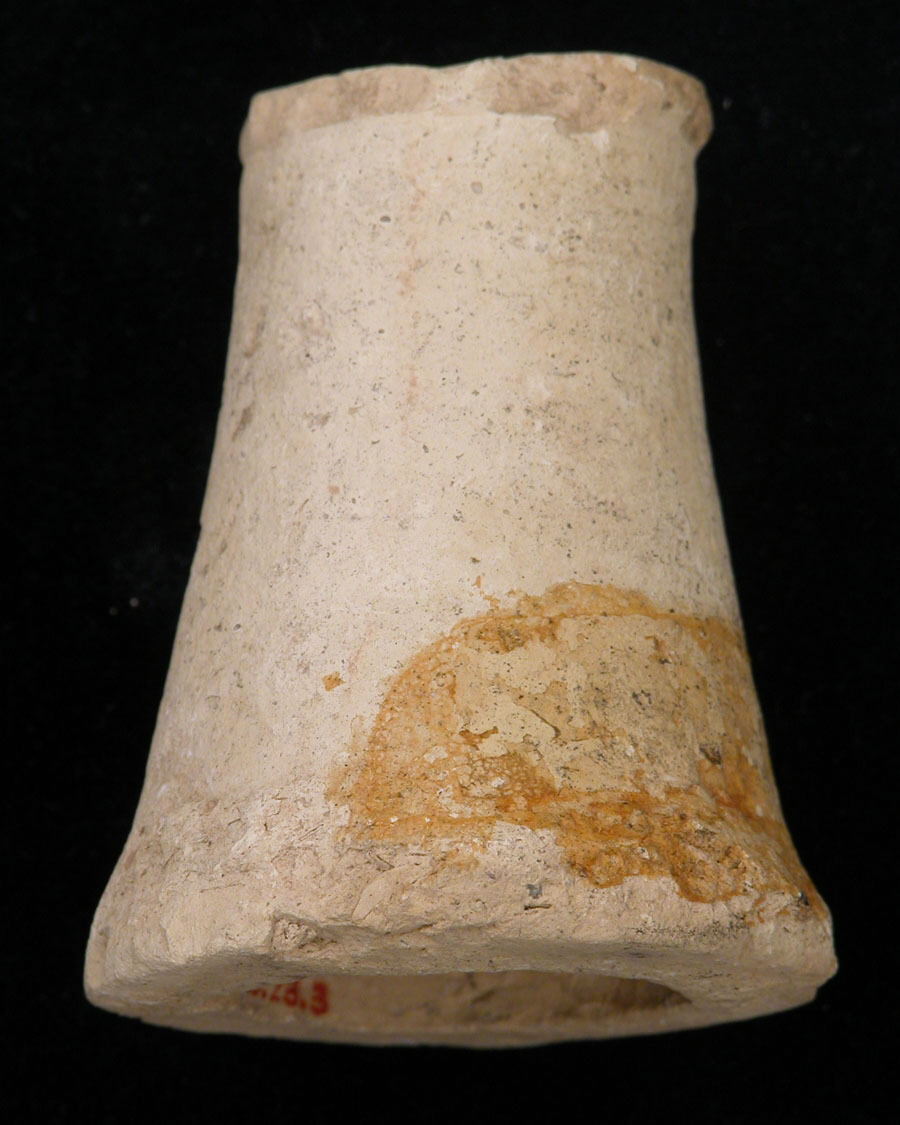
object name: fragment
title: Ceramic Fragment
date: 801-1000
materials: earthenware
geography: saudi arabia